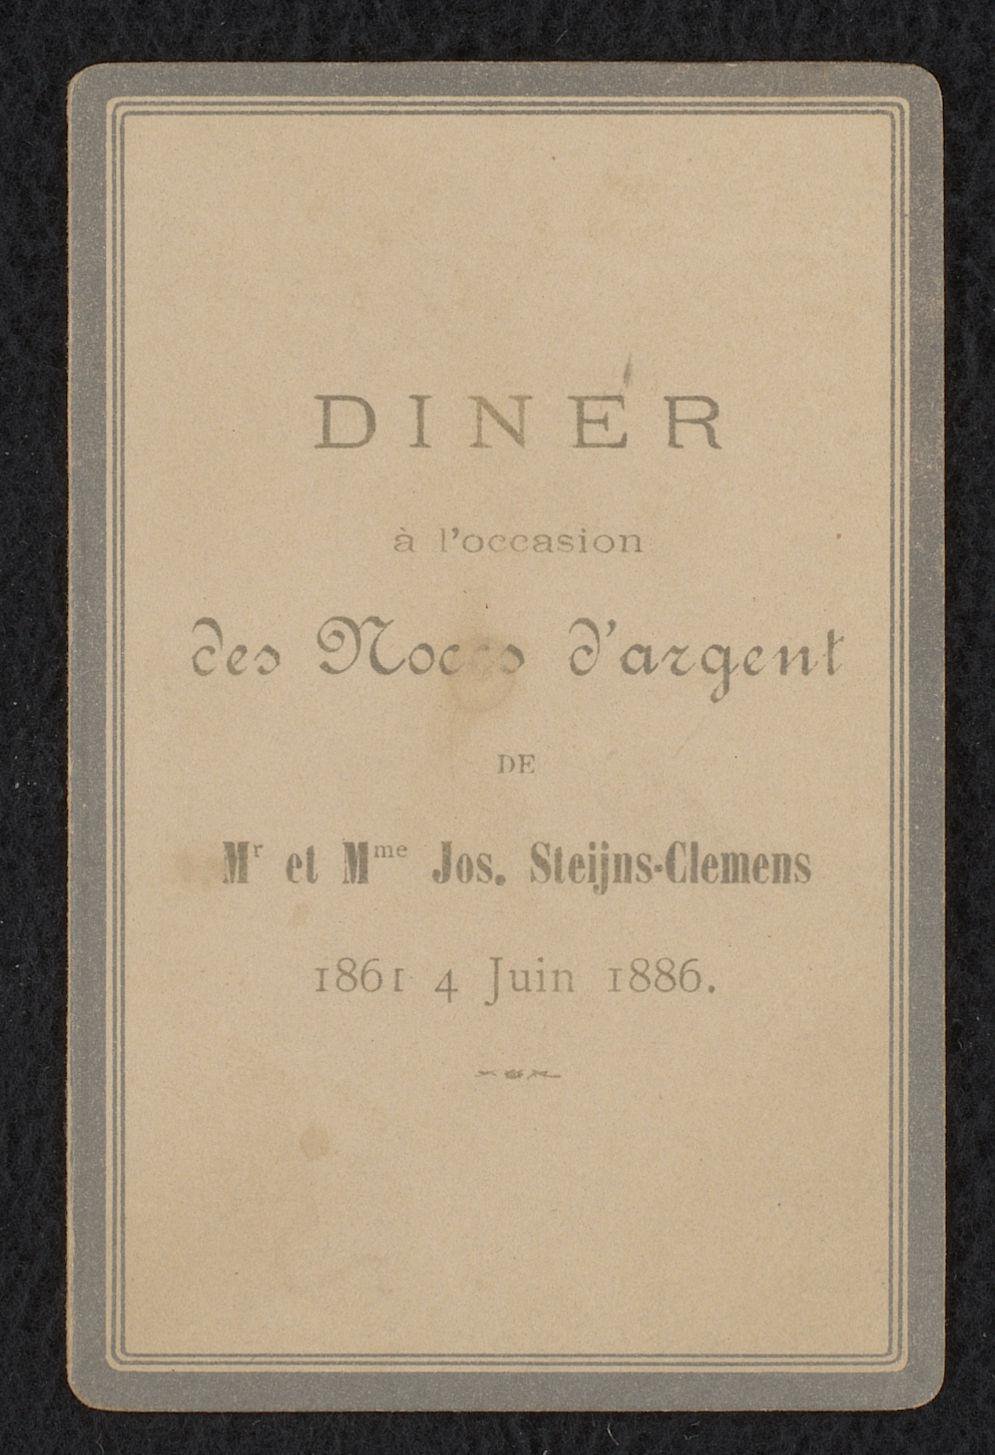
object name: print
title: Menu van het diner ter ere van het zilveren huwelijksjubileum van meneer en mevrouw Jos. Steijns-Clemens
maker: Anonymous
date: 1886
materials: paper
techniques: lithograph, pen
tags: maastricht, marriage, married couple, 'matrimonium'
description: Dubbele kaart met op de voorzijde de details van het diner. Binnenin handgeschreven het menu. Op de achterzijde handgeschreven de naam van de genodigde ('Monsieur Emile Steijns Pharmacien').